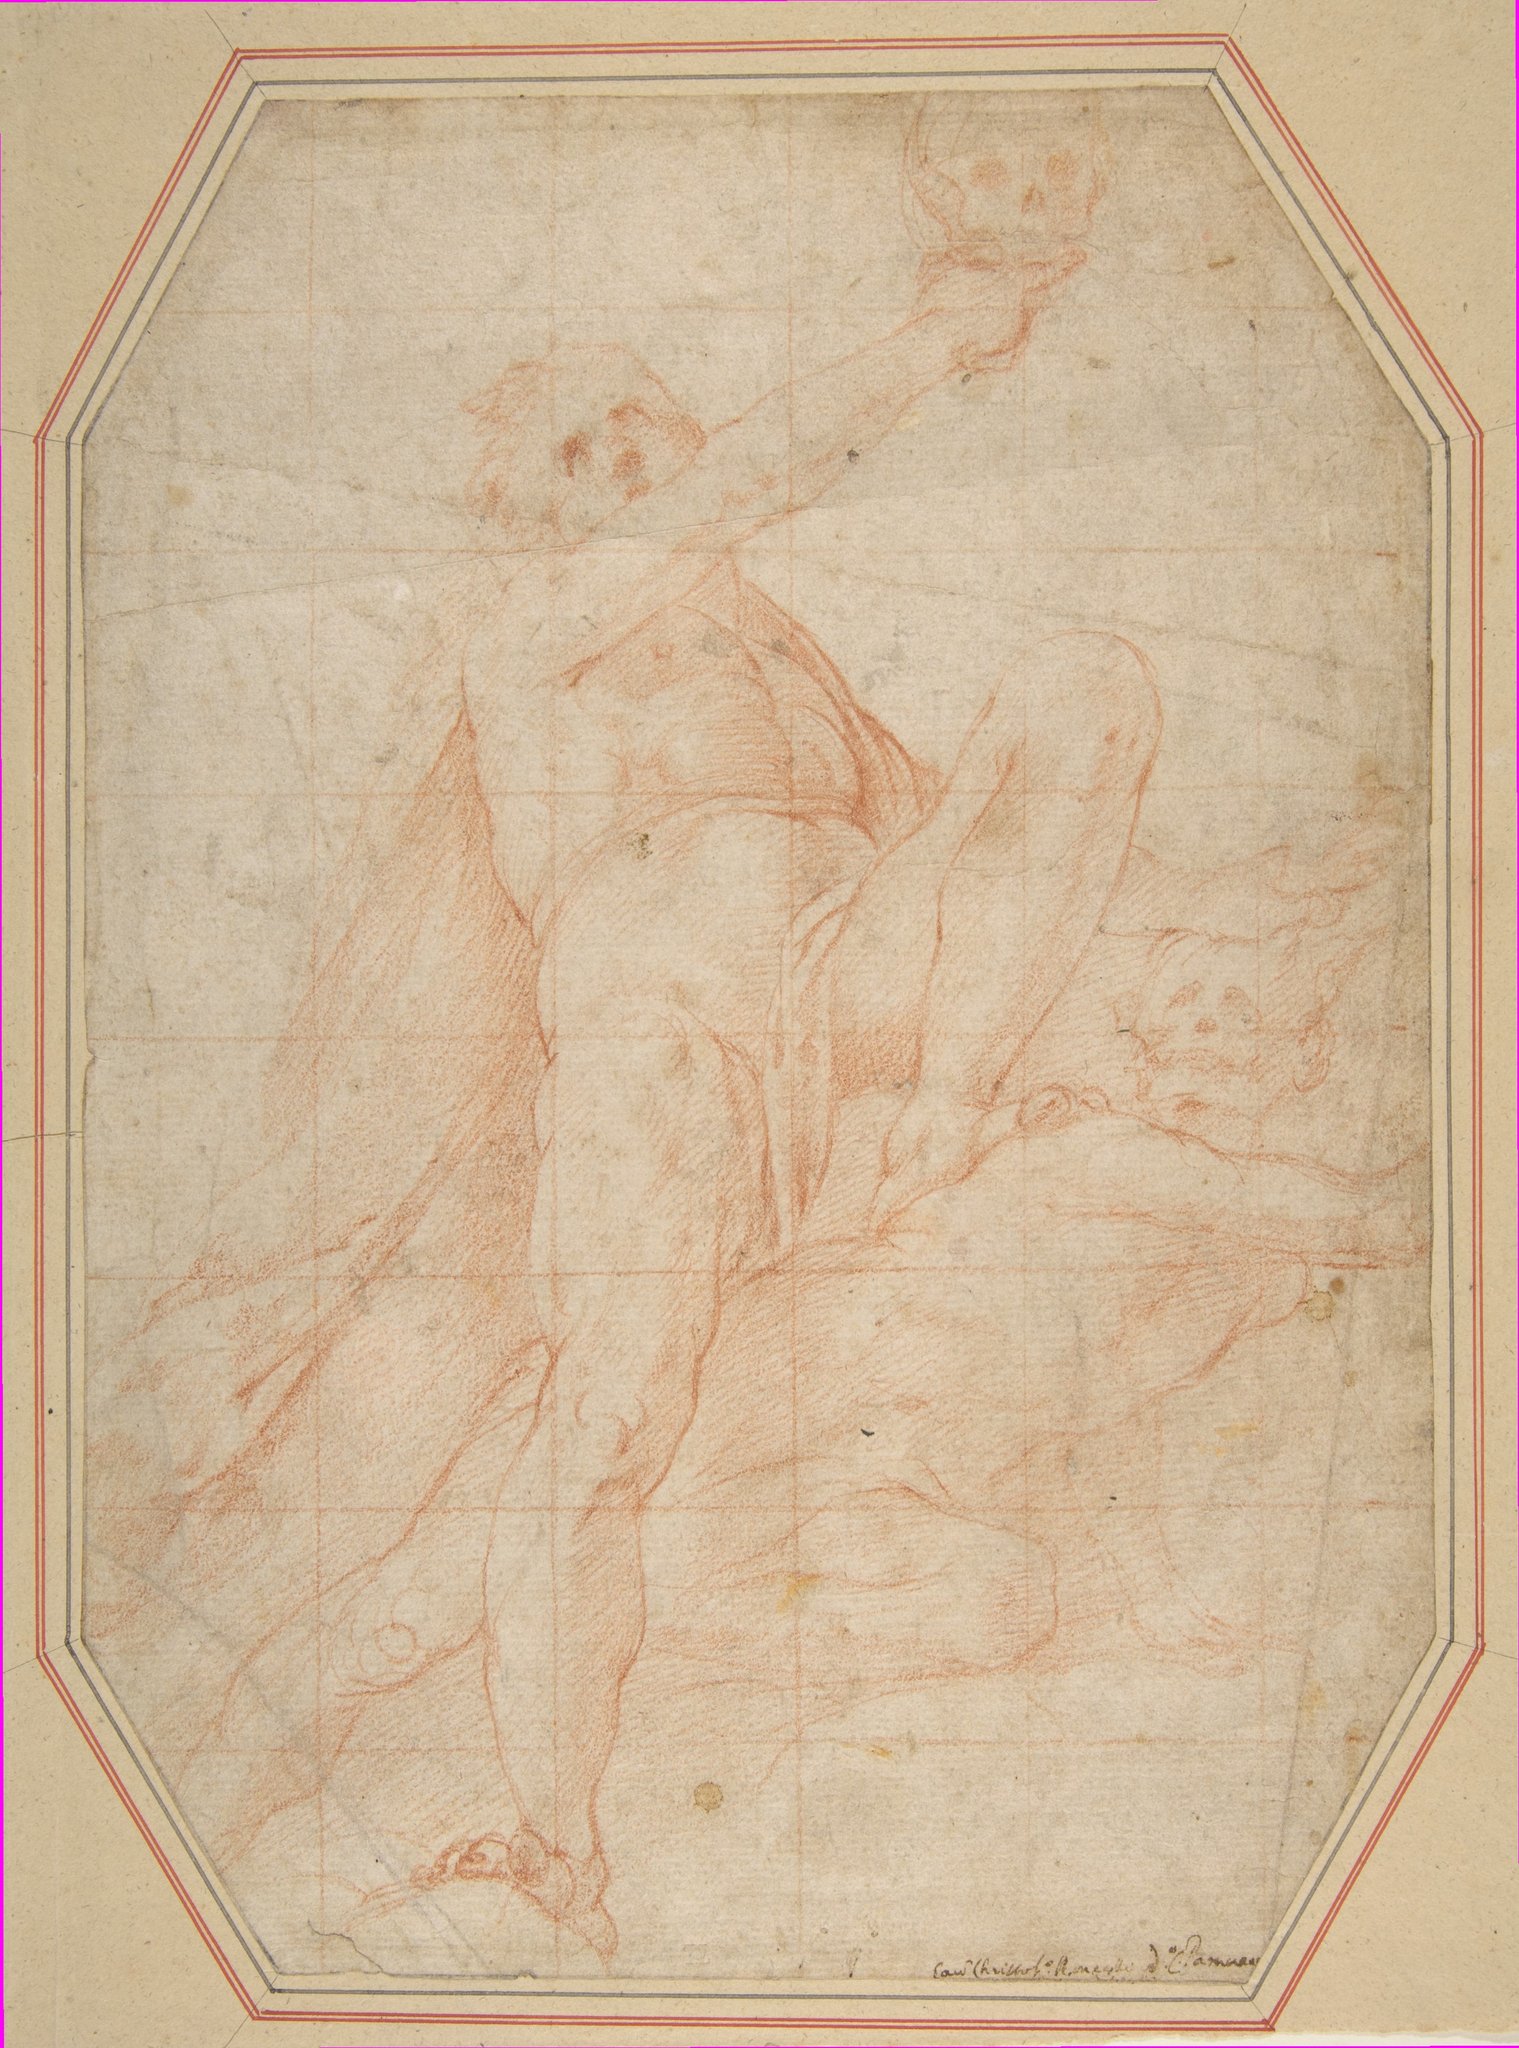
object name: drawing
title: Two Nudes Seen from Below (recto); Male Figure with Upraised Arm (verso)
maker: pomarancio (cristoforo roncalli)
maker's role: artist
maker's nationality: italian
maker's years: 1553-1626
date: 1580-1582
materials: chalk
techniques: drawing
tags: male nudes